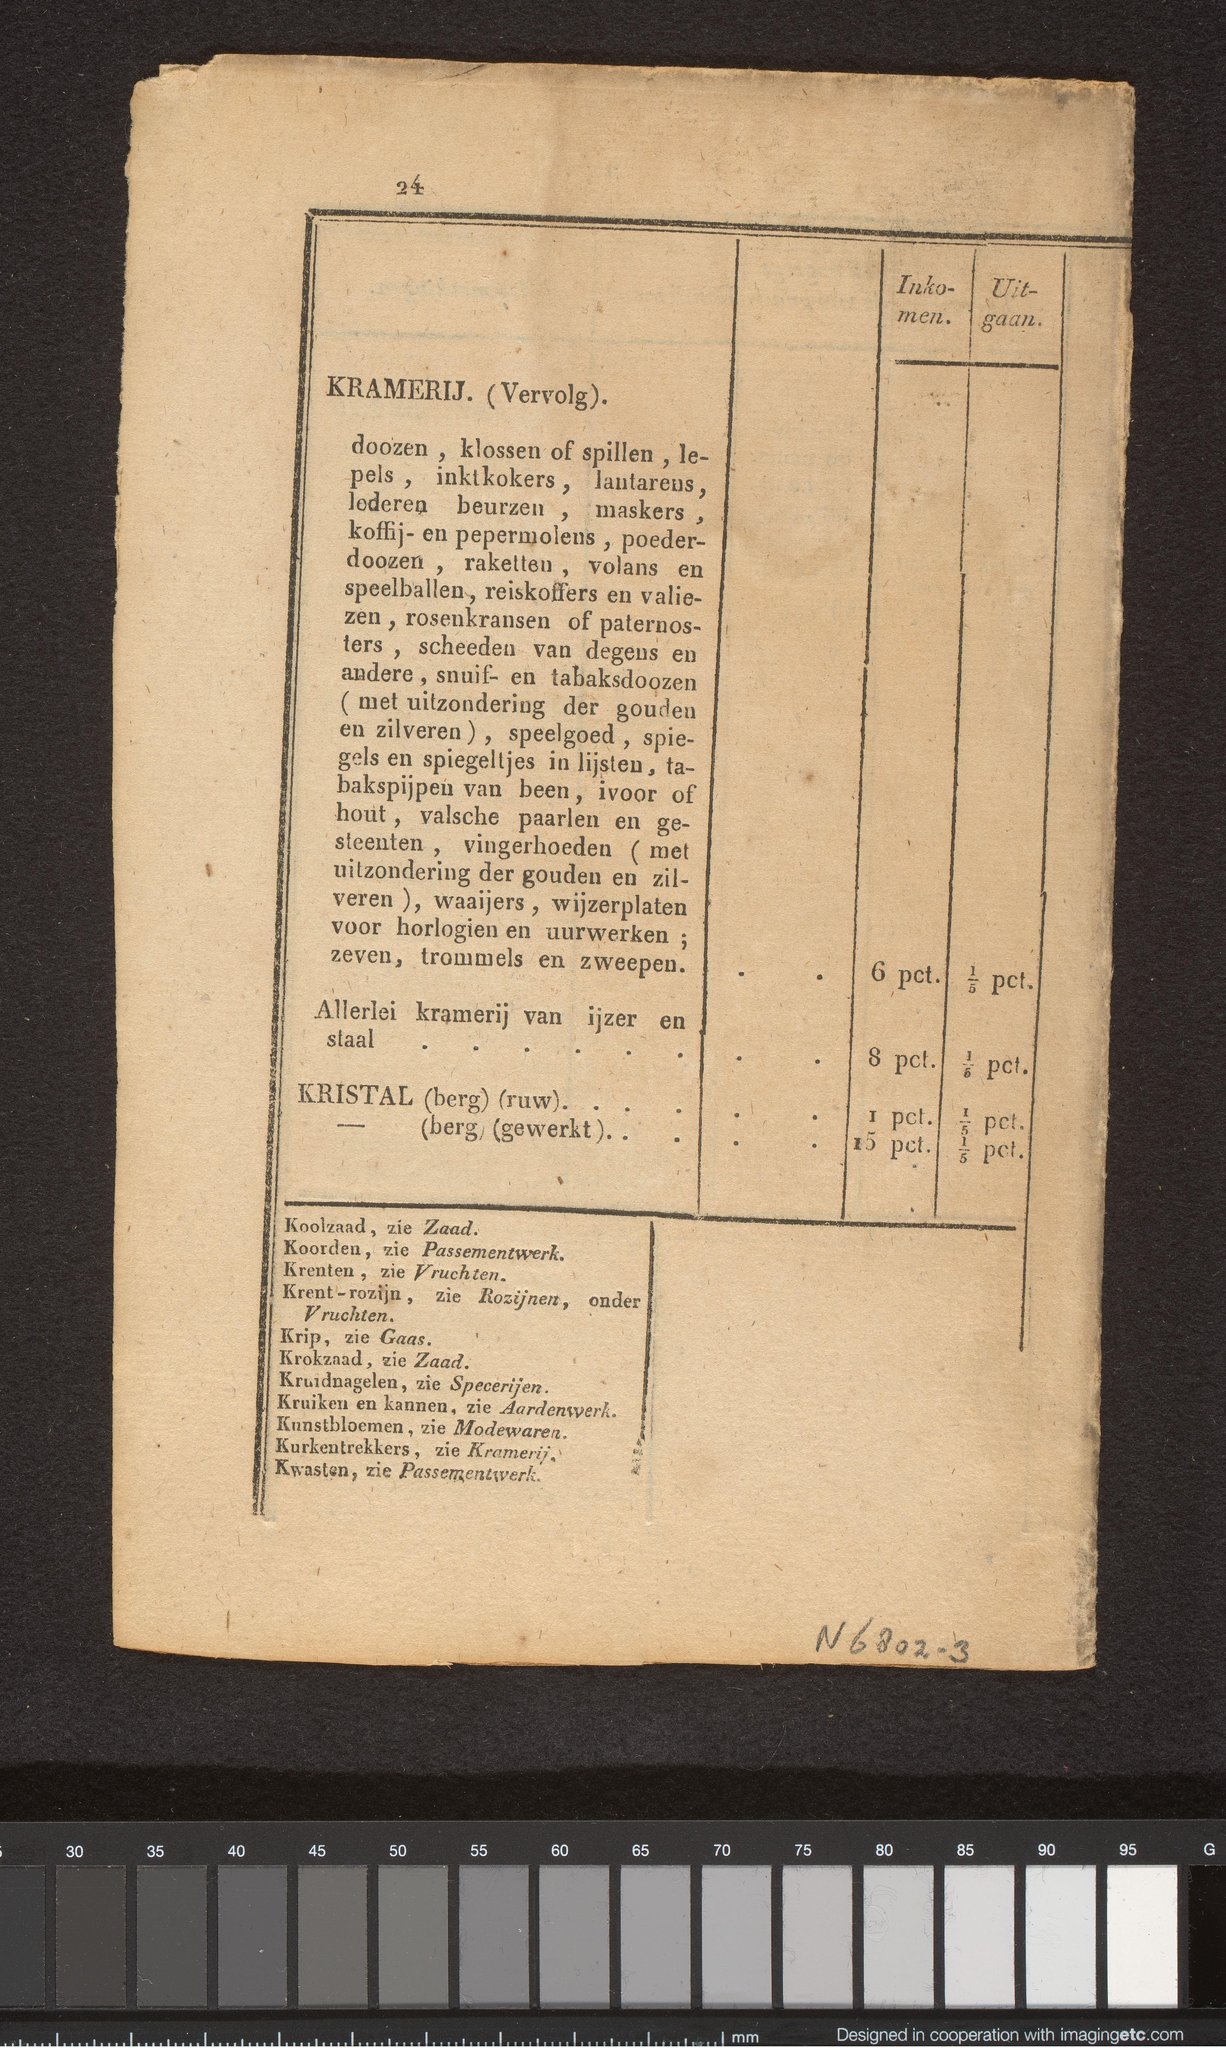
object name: brochure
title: Lijst of tarief van inkomende en uitgaande regten op alle goederen en koopmanschappen welke het koningrijk der Nederlanden zullen worden in- of uitgevoerd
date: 1819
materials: paper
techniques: folding, printing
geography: netherlands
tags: netherlands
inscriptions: date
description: Katern van een losbladige brochure, lijst met kolommen waarin gegevens over diverse handelswaar. Gedateerd en gemerkt.